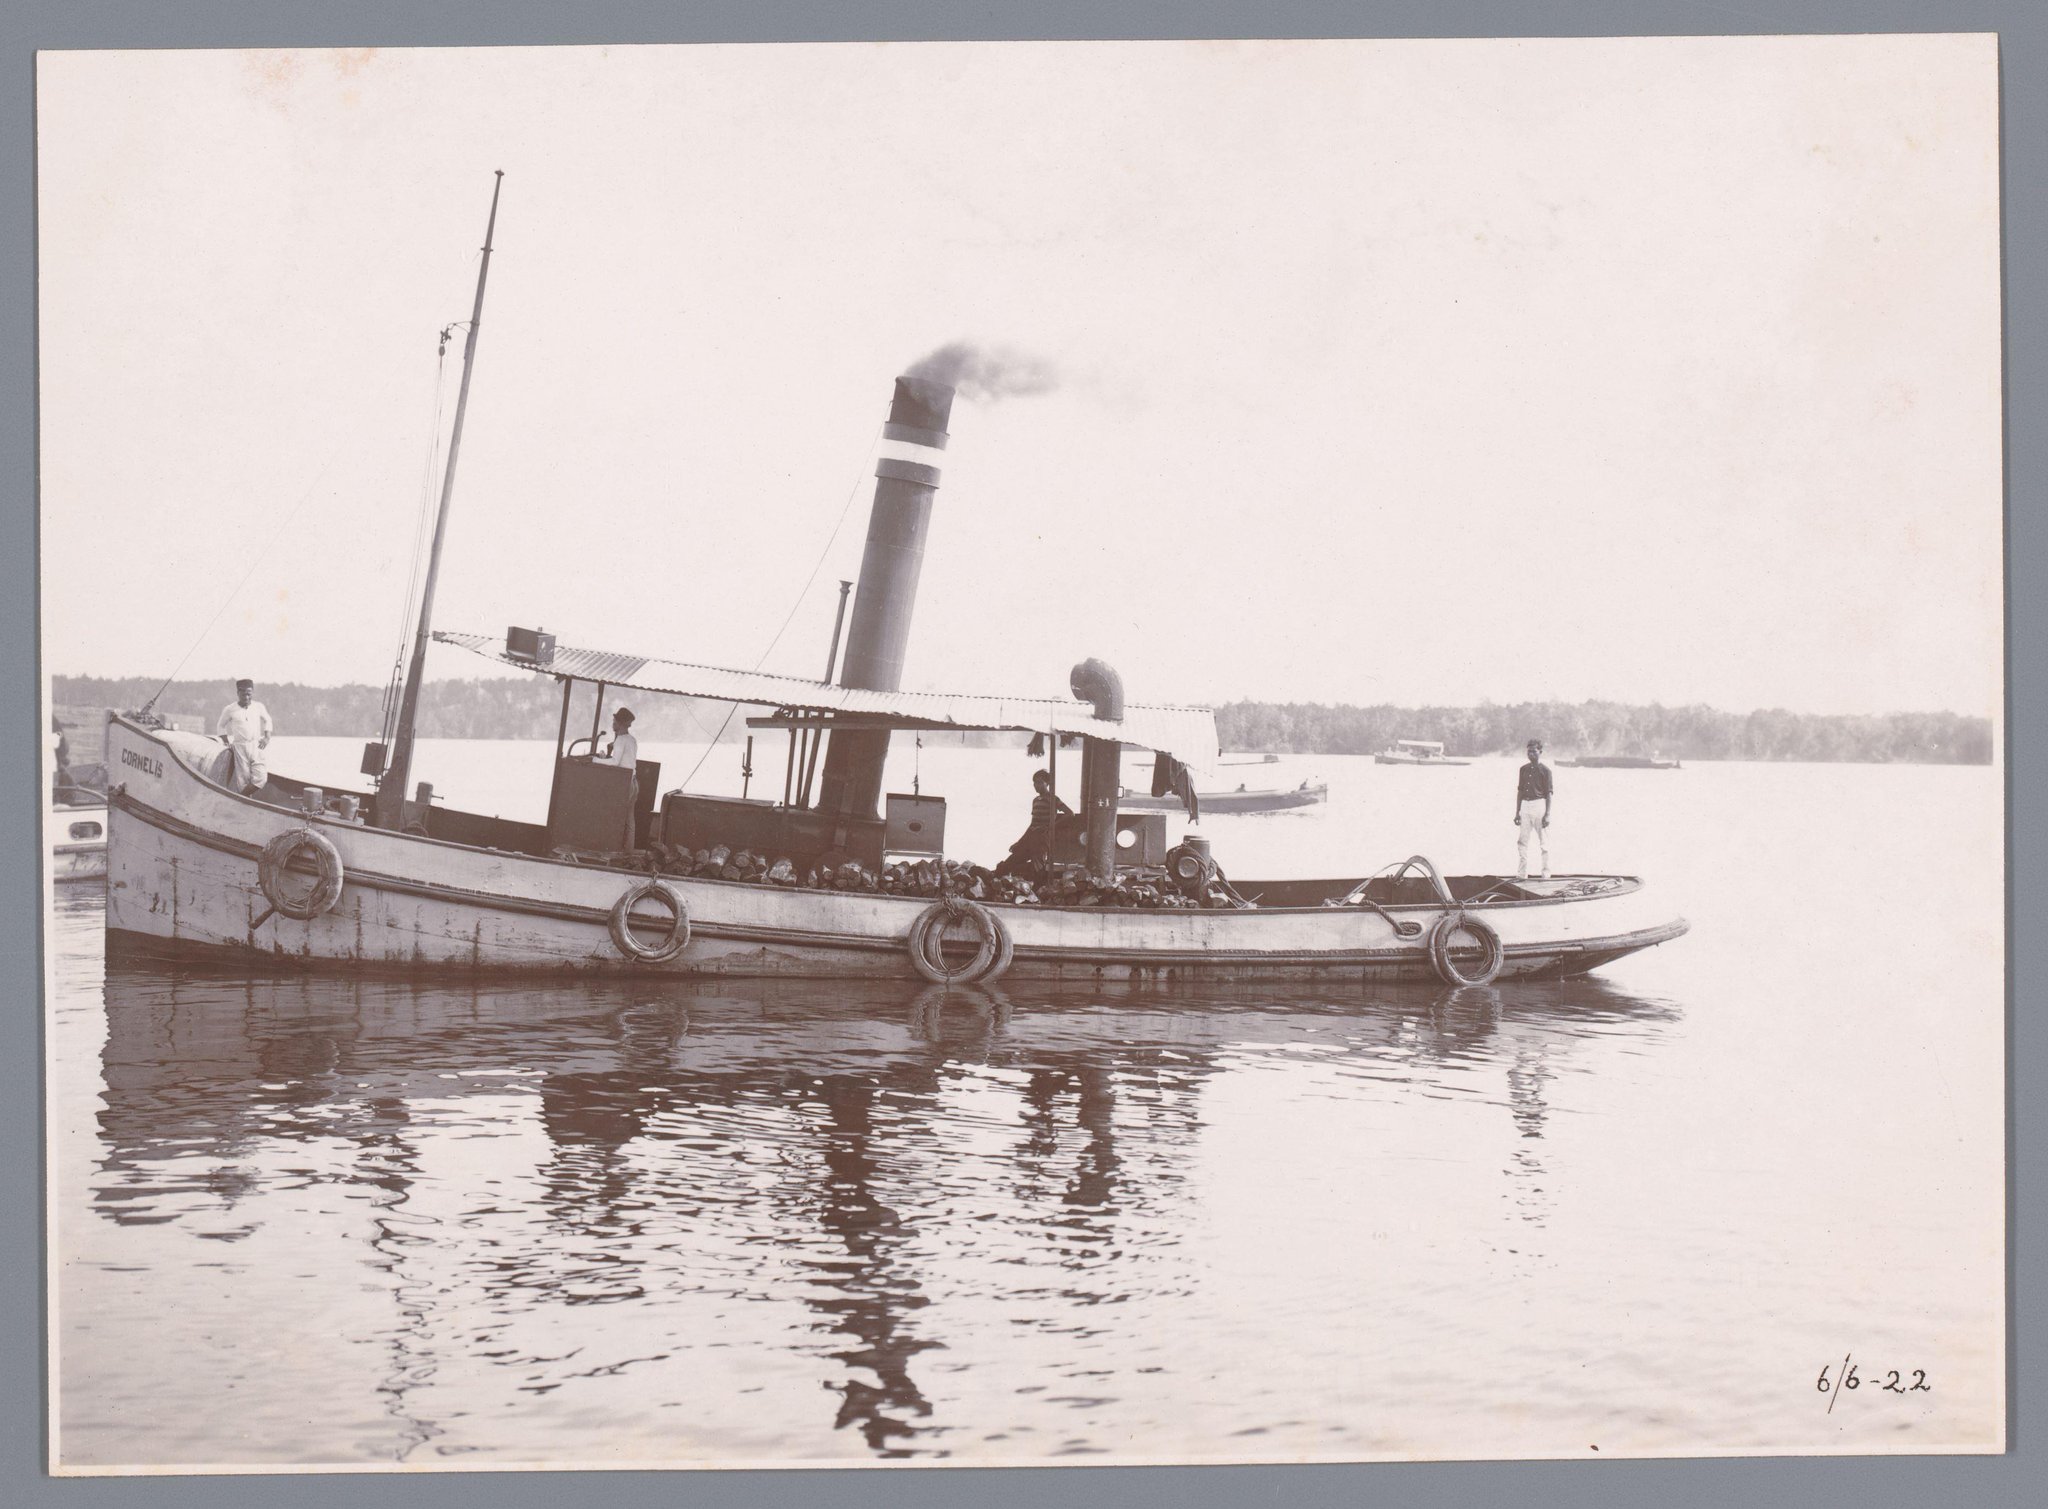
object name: photograph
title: Oceaanhaven Belawan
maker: Anonymous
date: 1922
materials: photographic support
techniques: gelatin silver print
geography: belawan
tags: harbour, building-site, steamship, motorship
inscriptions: date: ‘6/6-22’, inscription: ‘No 168 Sleepboot "Cornelis"’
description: De sleepboot "Cornelis". Genummerd: 168. Onderdeel van de groep van losse foto's over de aanleg van de haven Belawan aan de kust voor Medan, Sumatra 1921-1922.